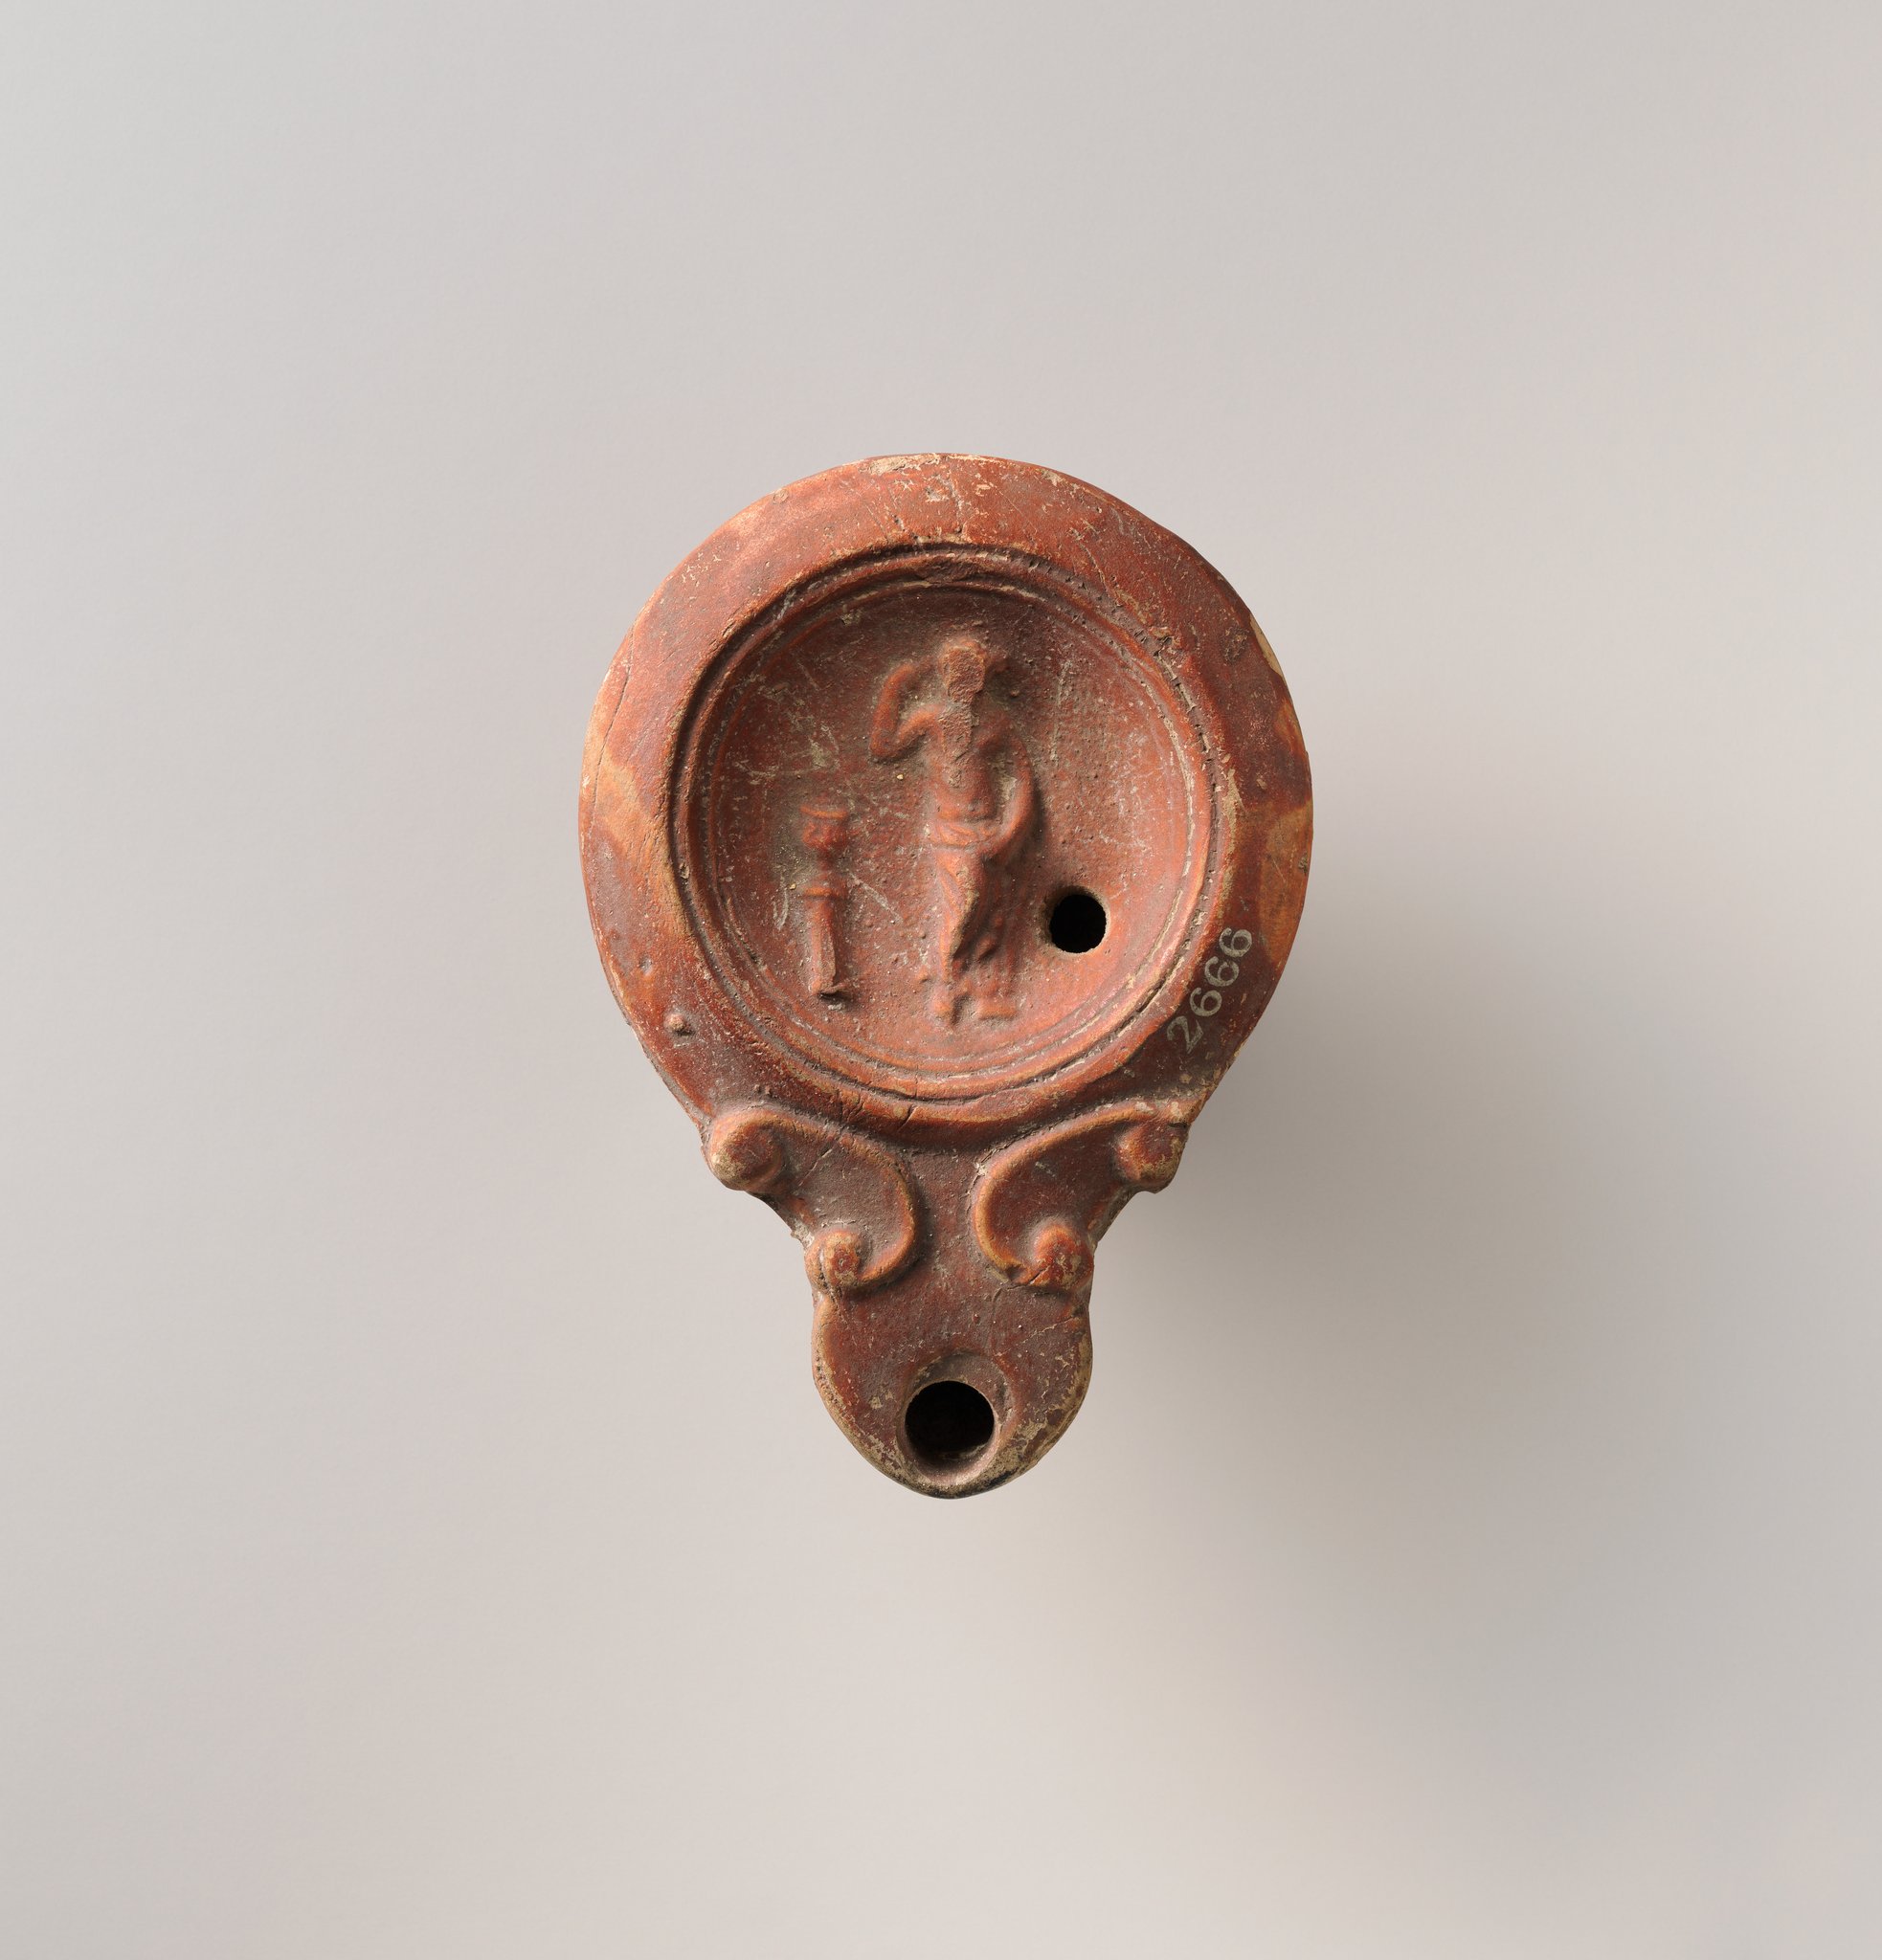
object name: lamp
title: Terracotta oil lamp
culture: roman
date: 1-100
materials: terracotta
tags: men